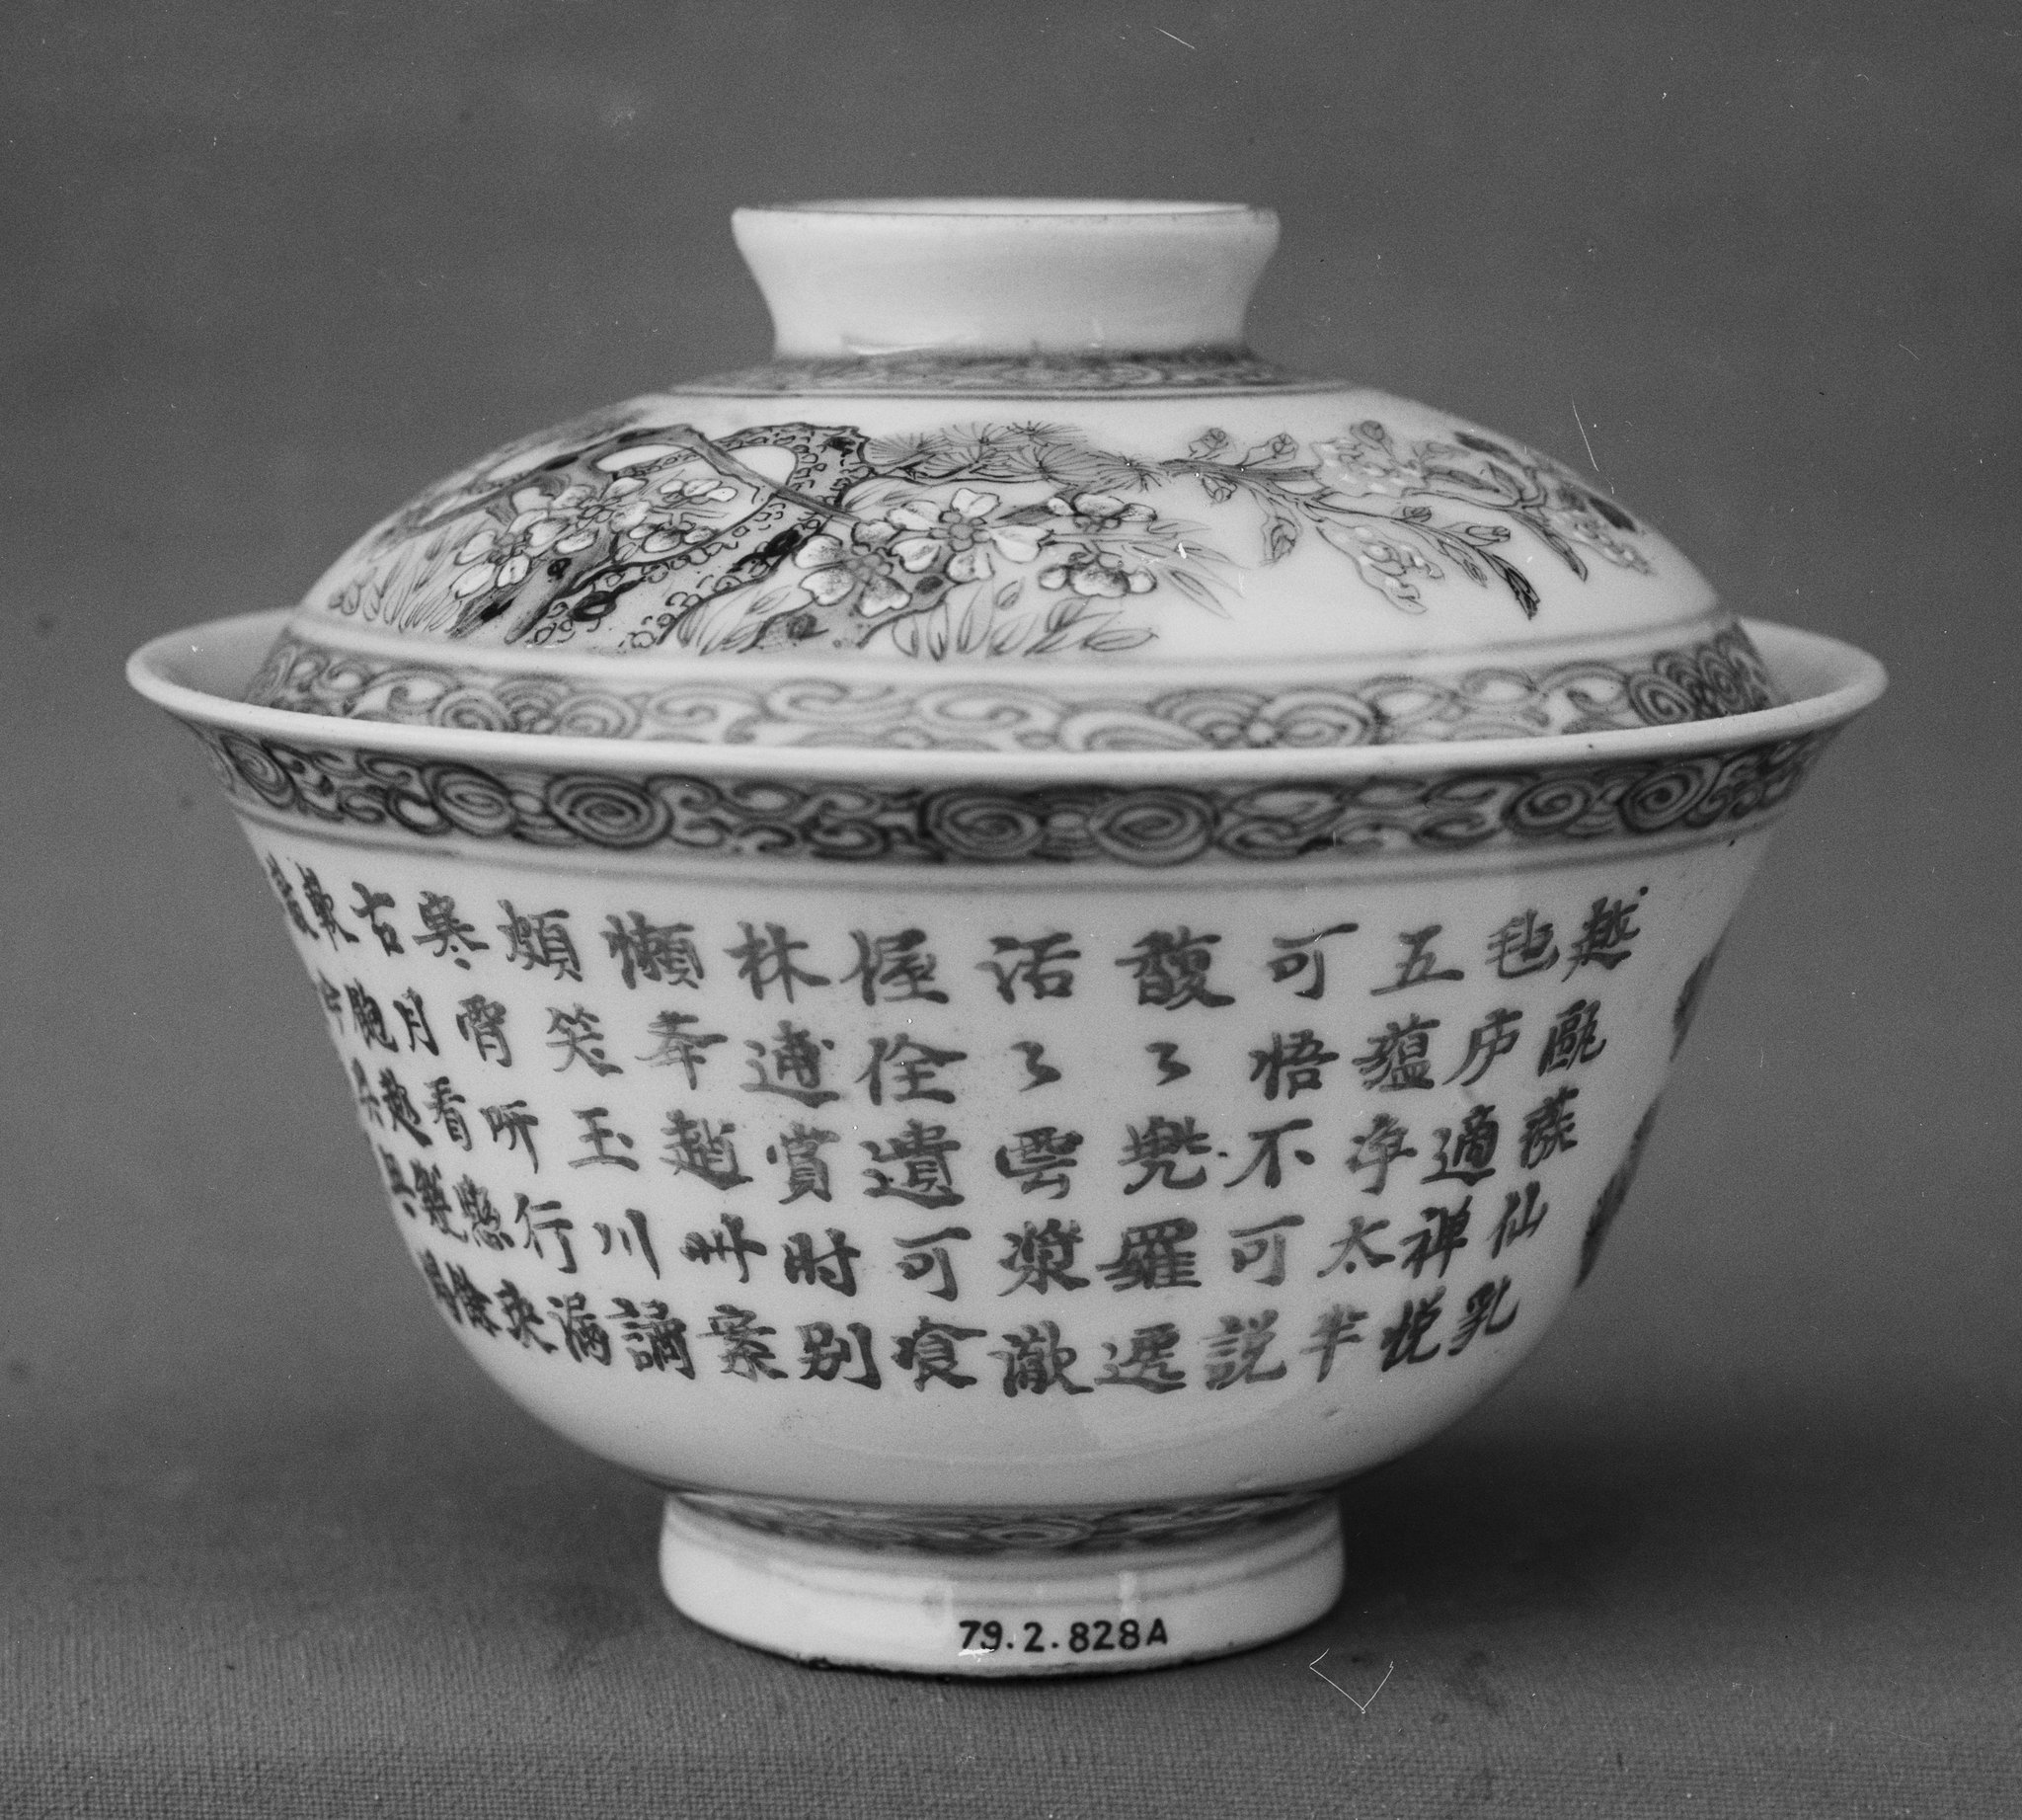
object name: covered bowl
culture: chinese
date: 1796-1820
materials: enamel, gilt, porcelain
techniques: overglaze, painting, polychrome, underglaze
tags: flowers